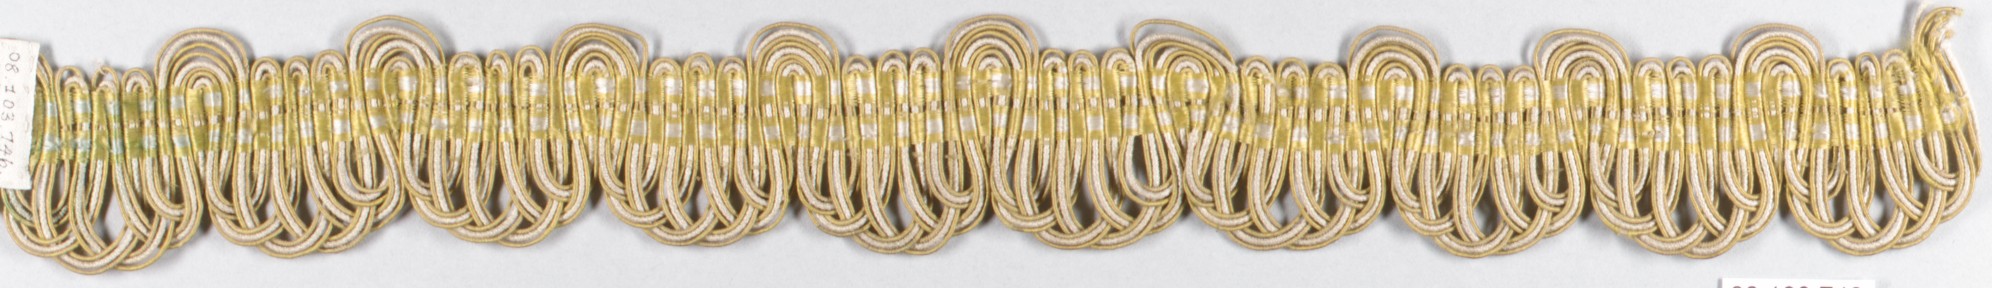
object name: gimp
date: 1701-1900